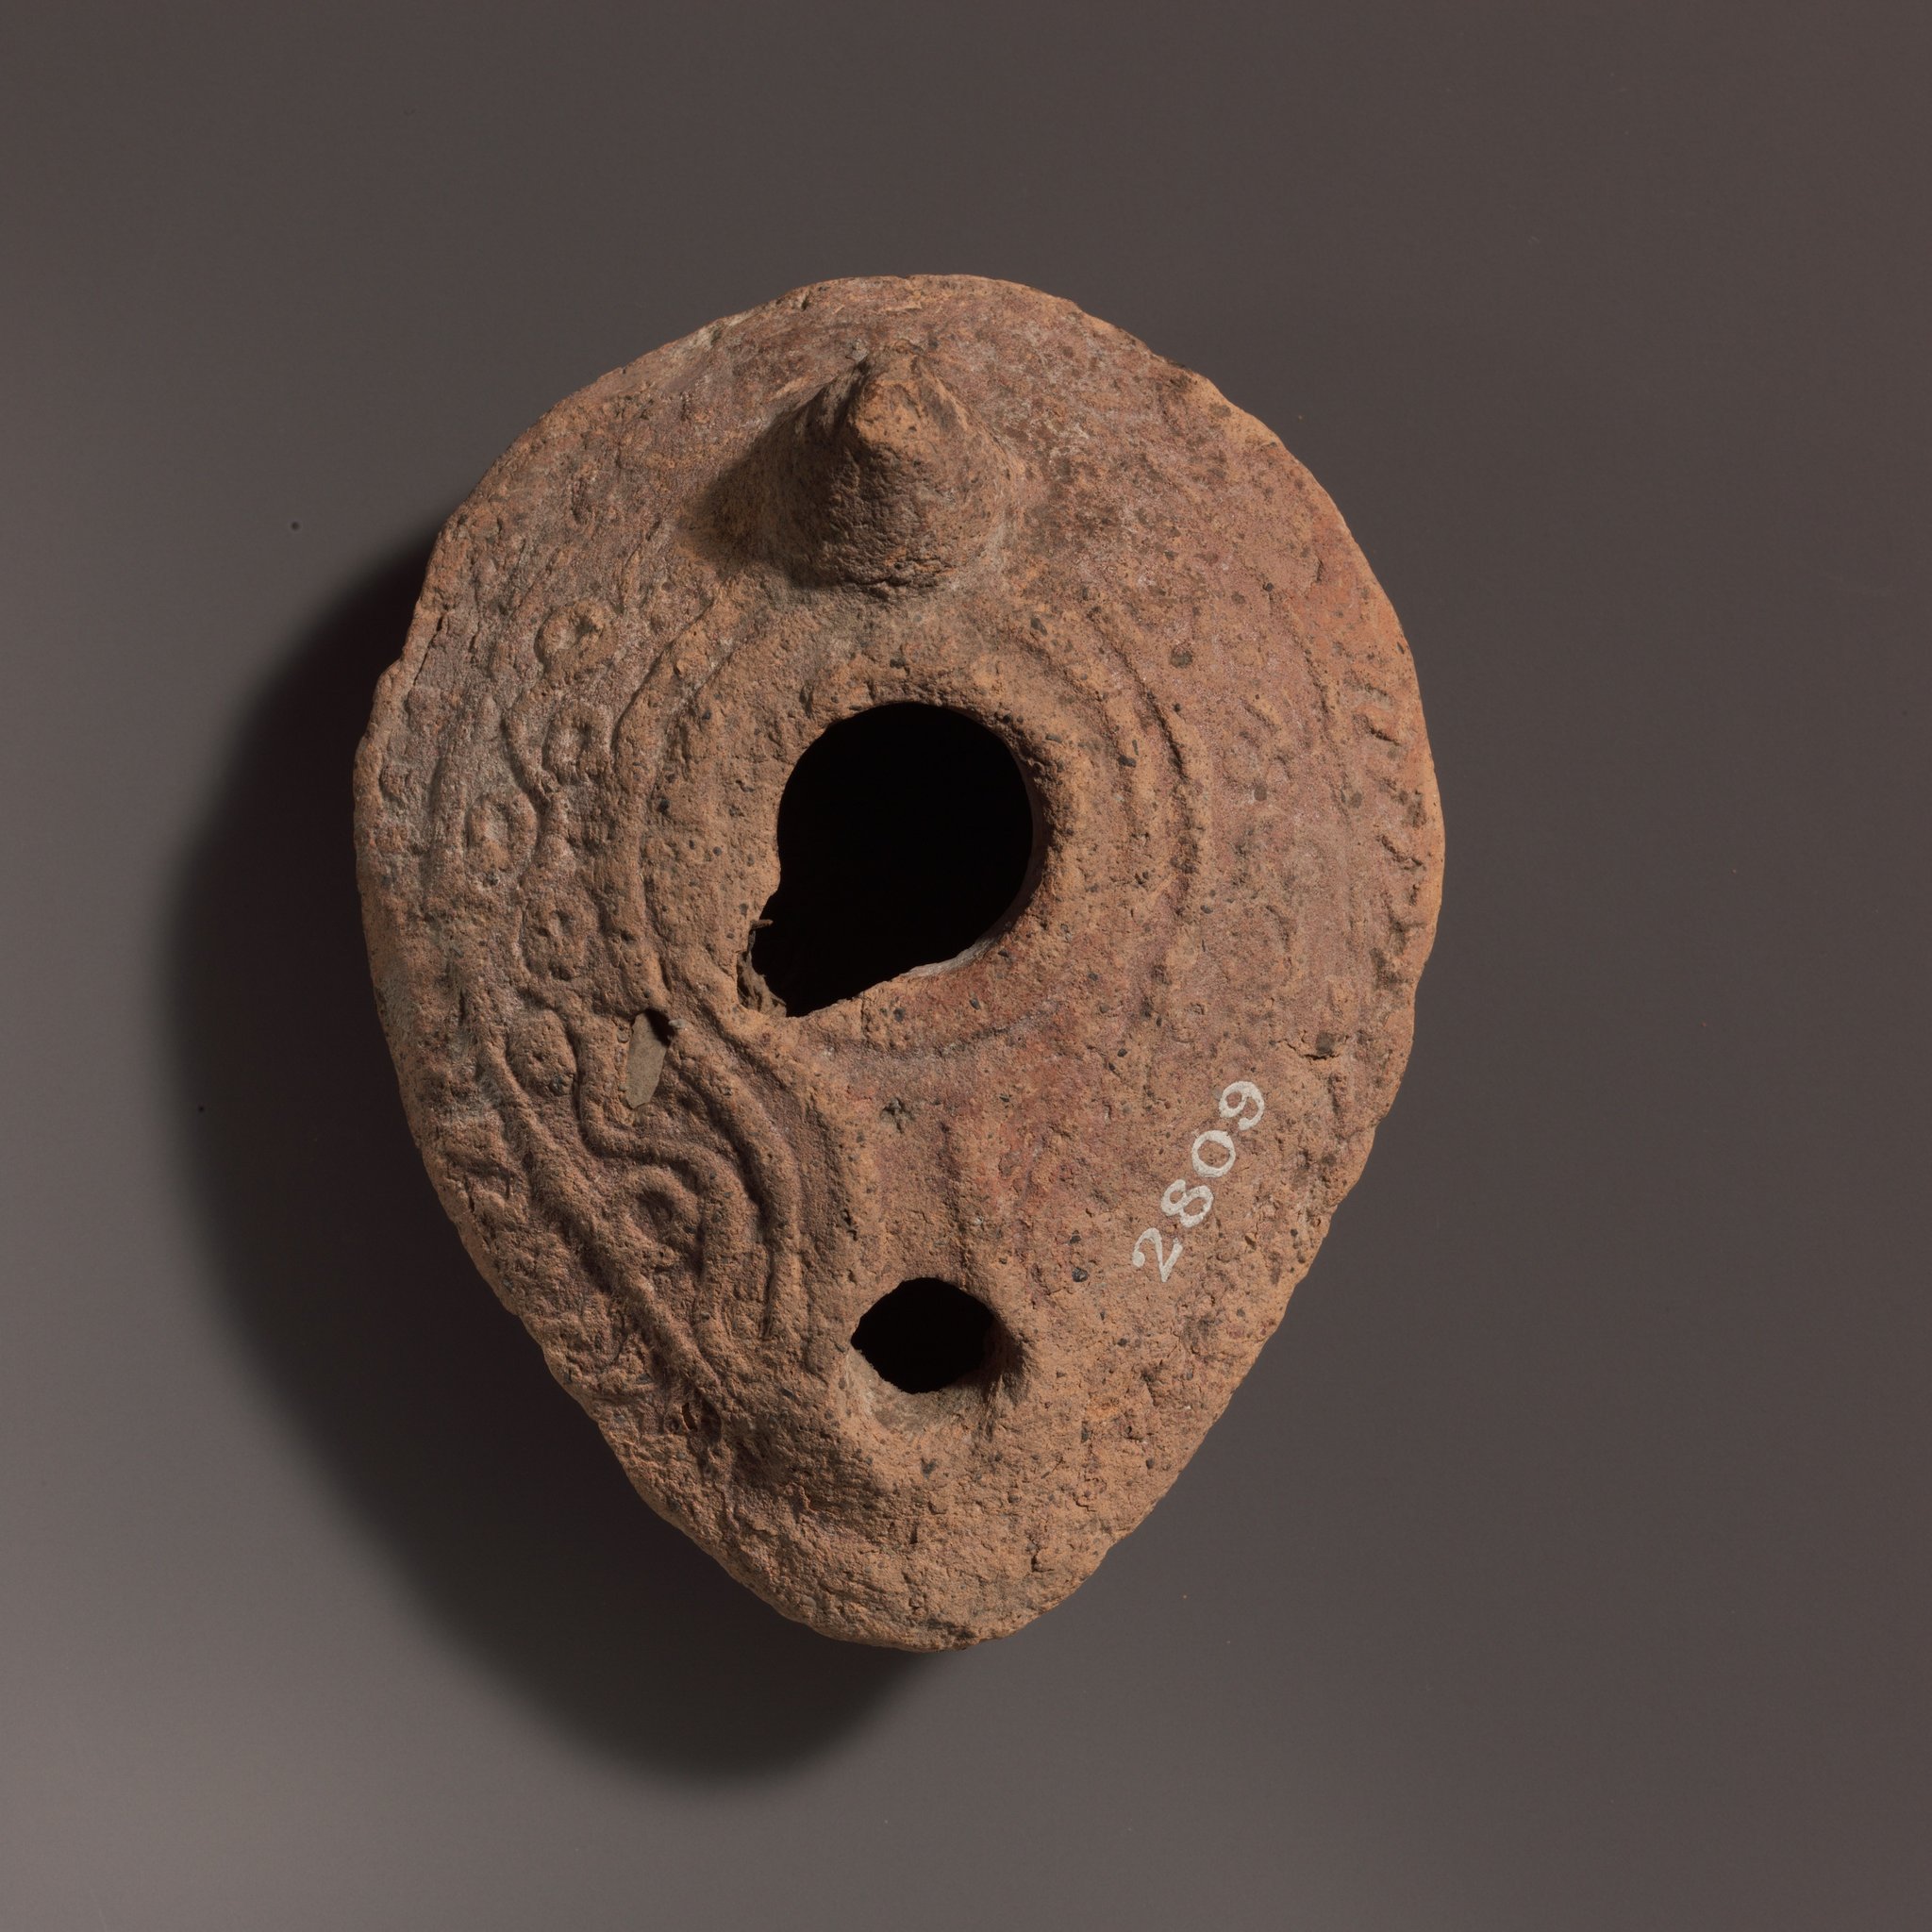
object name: lamp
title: Terracotta oil lamp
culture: roman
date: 601-700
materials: terracotta